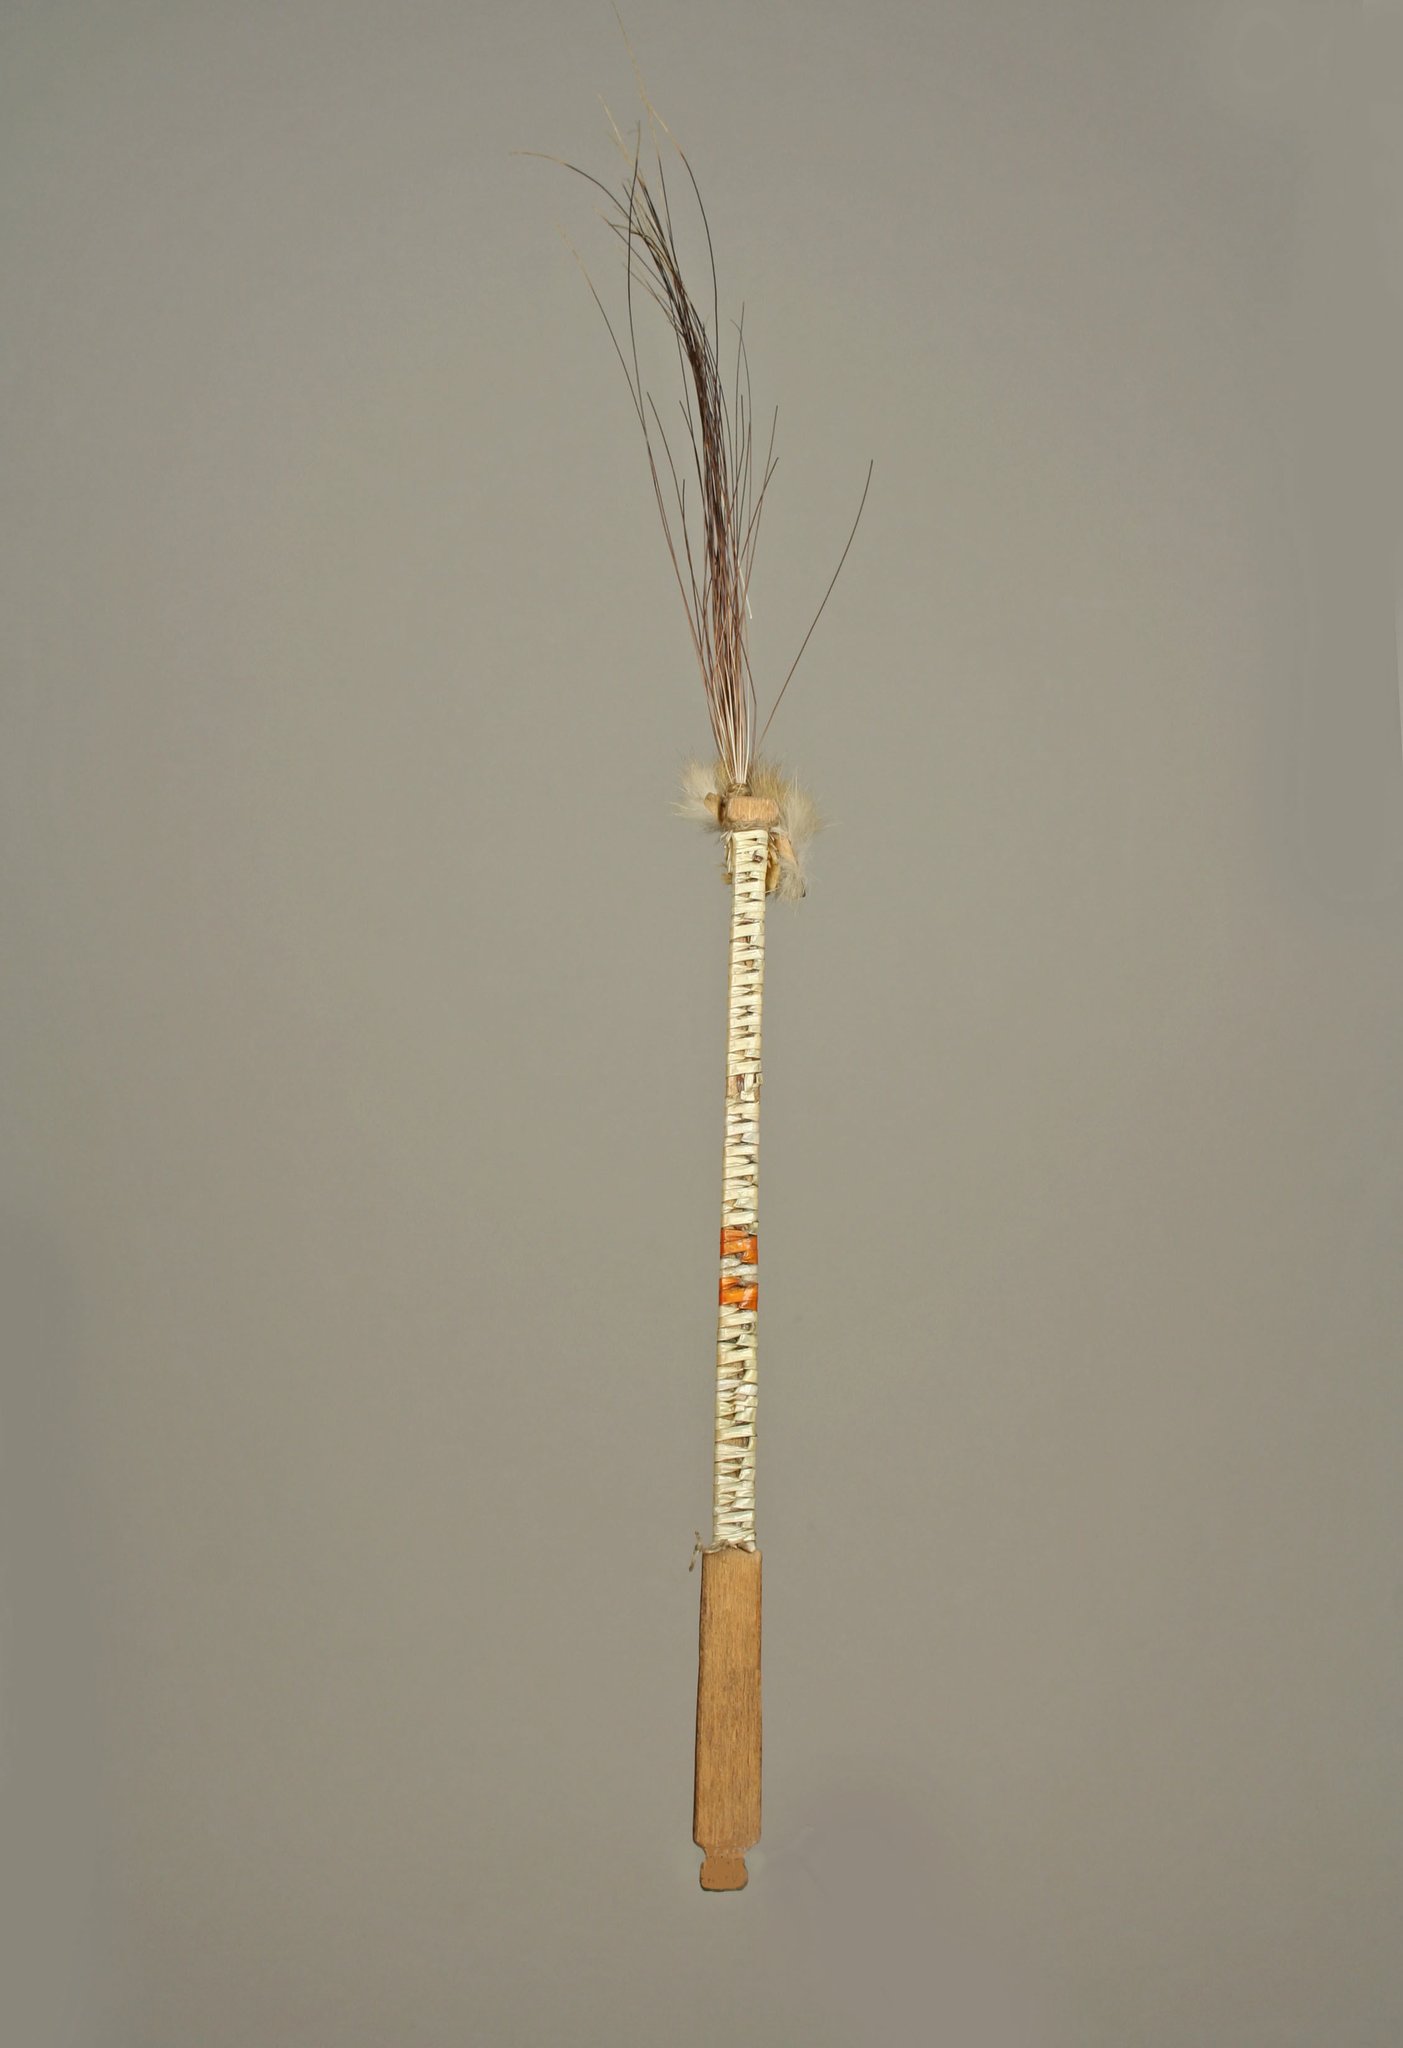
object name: feather symbol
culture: mesquakie or potawatomi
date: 1790-1890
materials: feather, wood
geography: united states